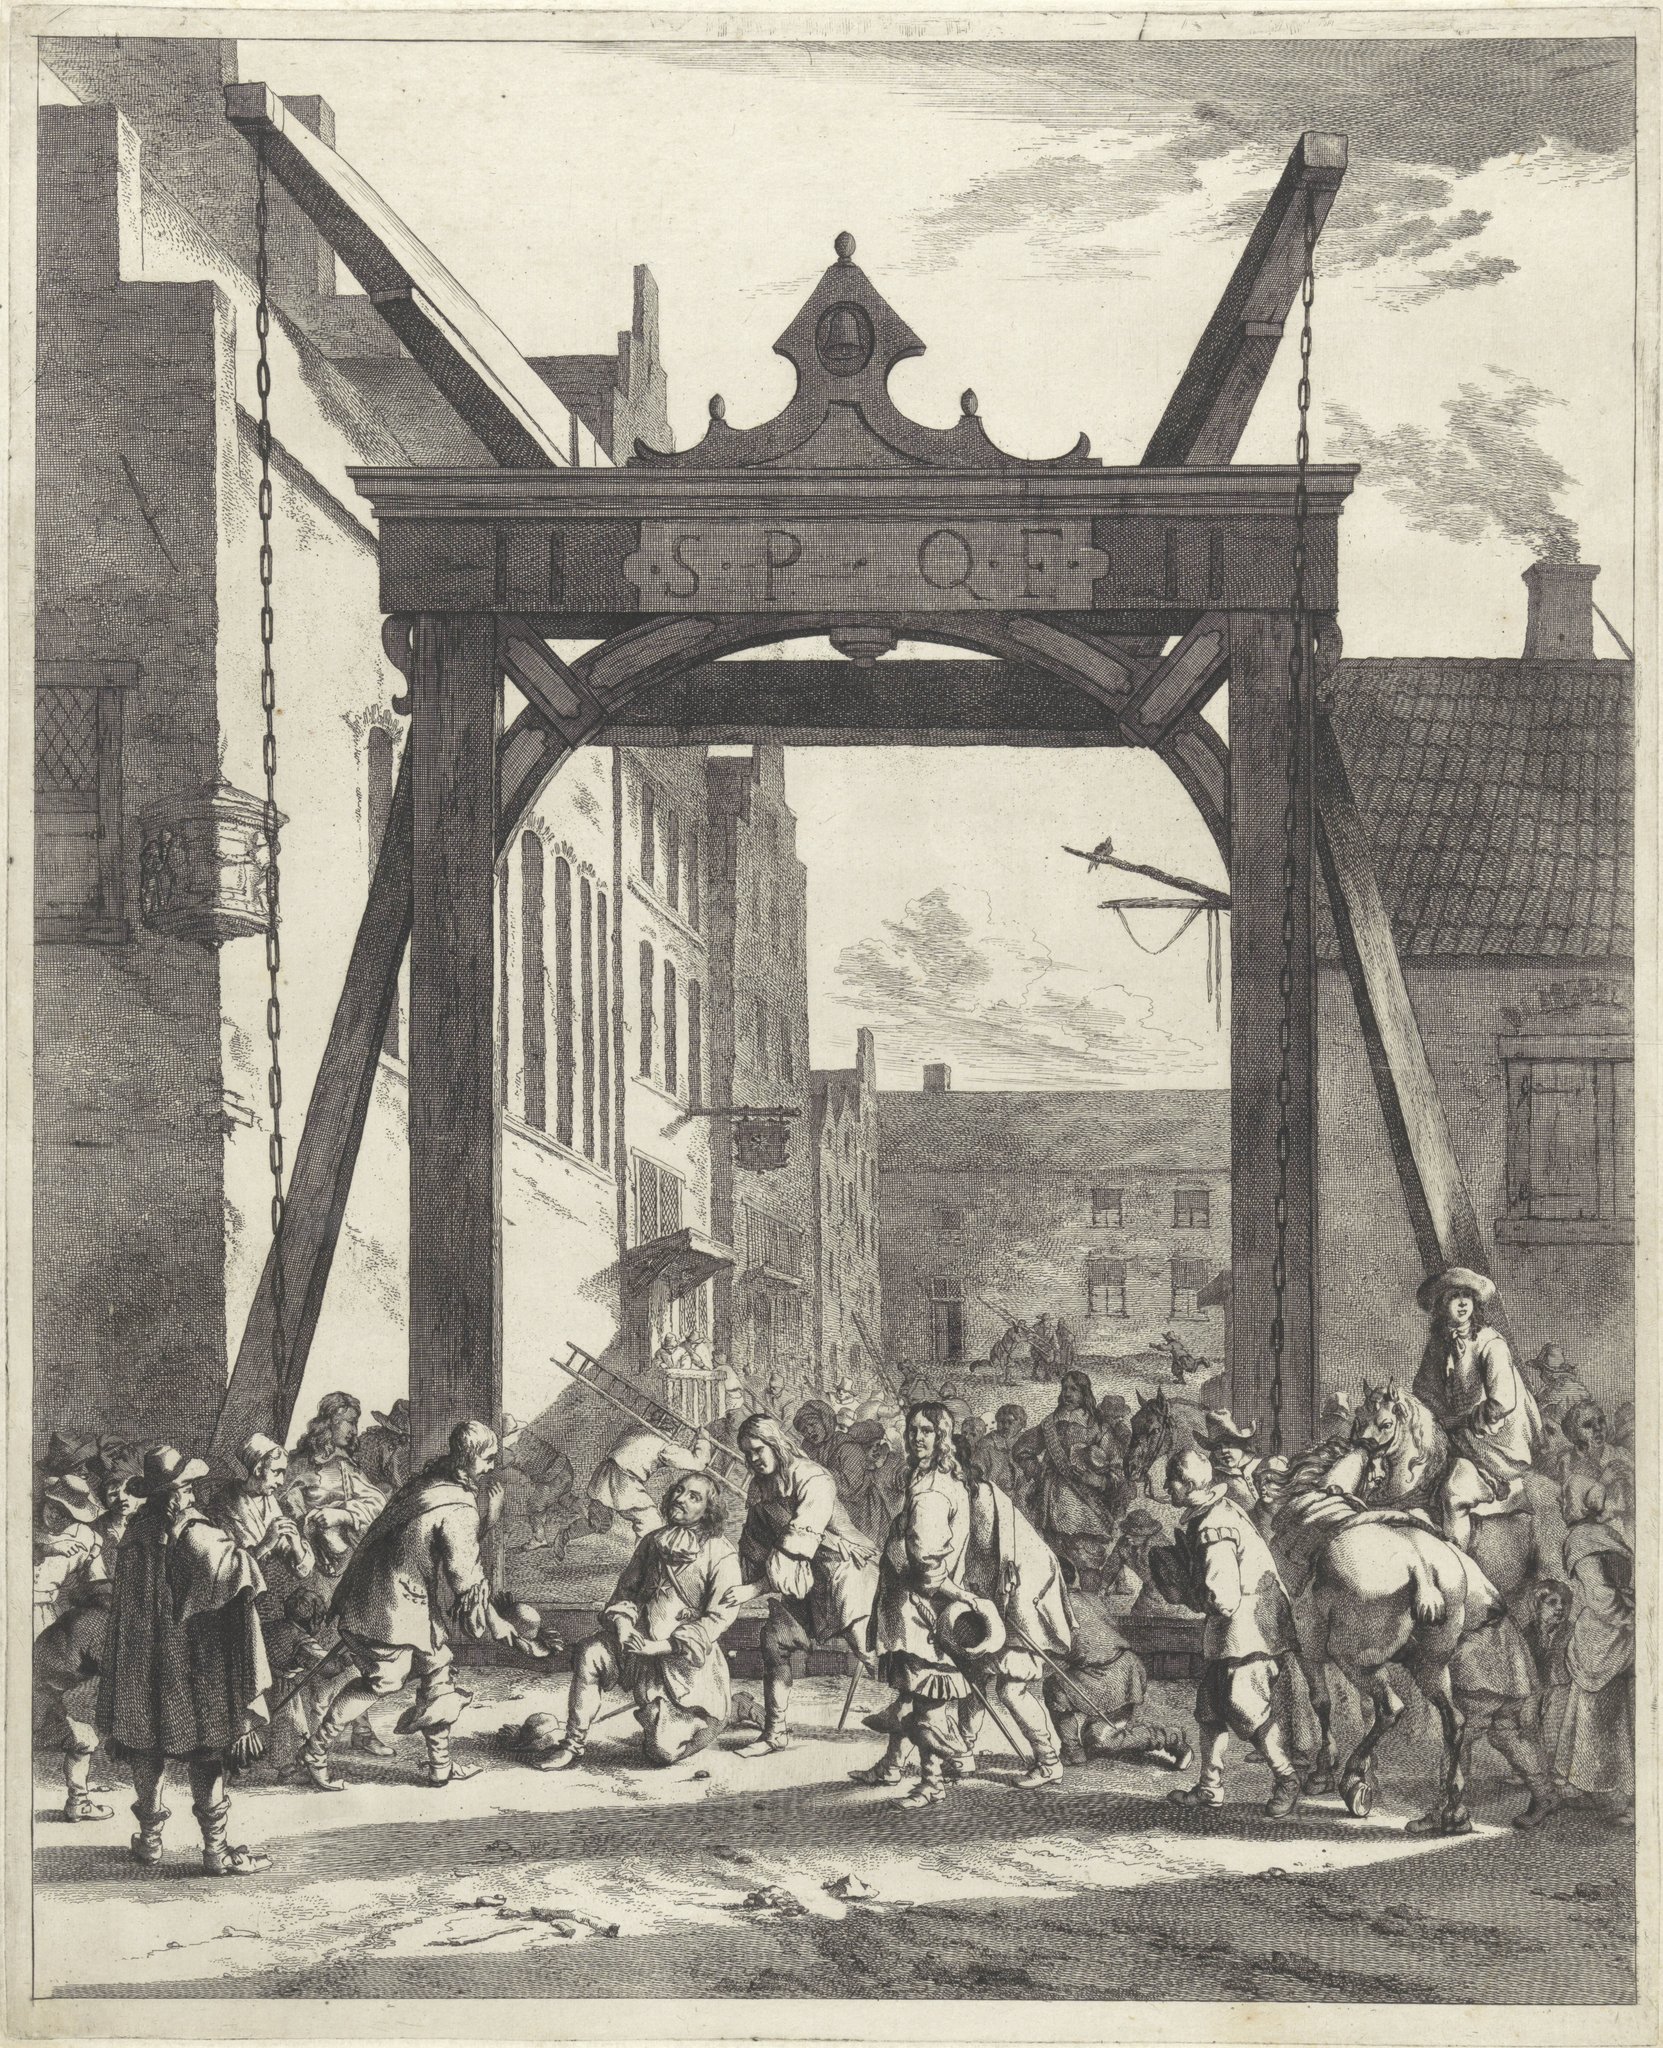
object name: print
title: Dankzegging door graaf Johan Maurits na het ongeluk op de brug van Franeker, 1665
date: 1665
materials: paper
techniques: etching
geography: northern netherlands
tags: earl, johan maurits graaf van nassau-siegen, collapsing building, bridge, accident with horse (or kindred animal), one person praying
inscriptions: collector's mark: Lugt 240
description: Dankzegging door graaf Johan Maurits na zijn redding na het ongeluk op de brug van Franeker, 1665, 6 januari 1665. De graaf knielt bij de ingestorte ophaalbrug.